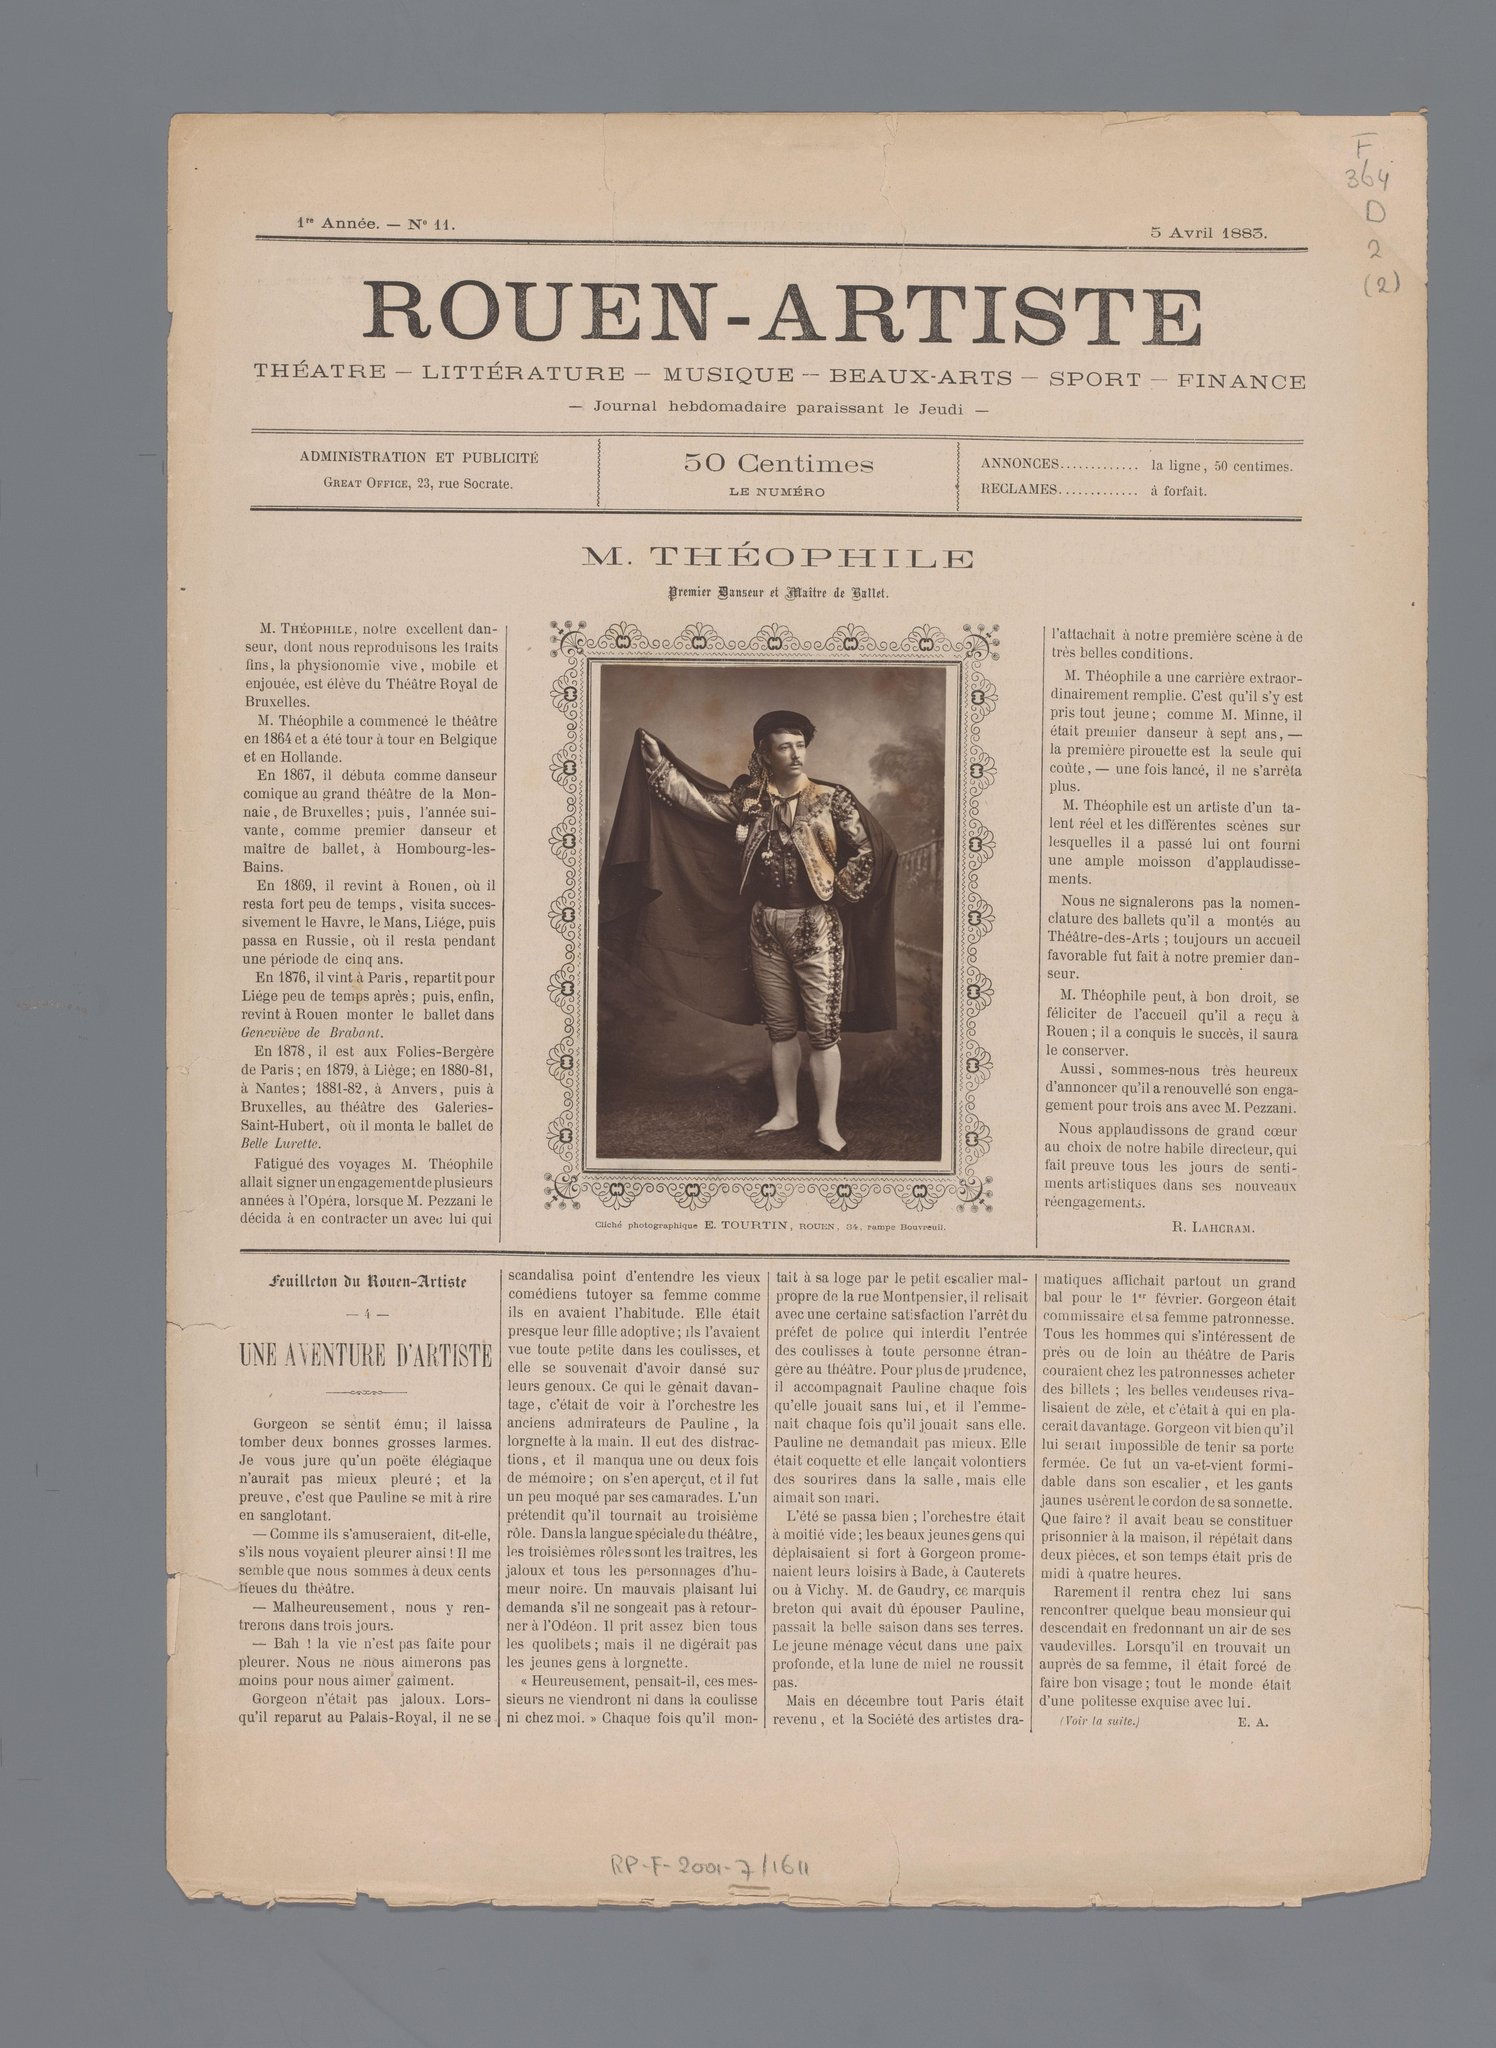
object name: magazine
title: Rouen-artiste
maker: léon brière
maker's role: printer, publisher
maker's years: 1837-1900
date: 1883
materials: paper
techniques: printing, woodburytype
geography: rouen